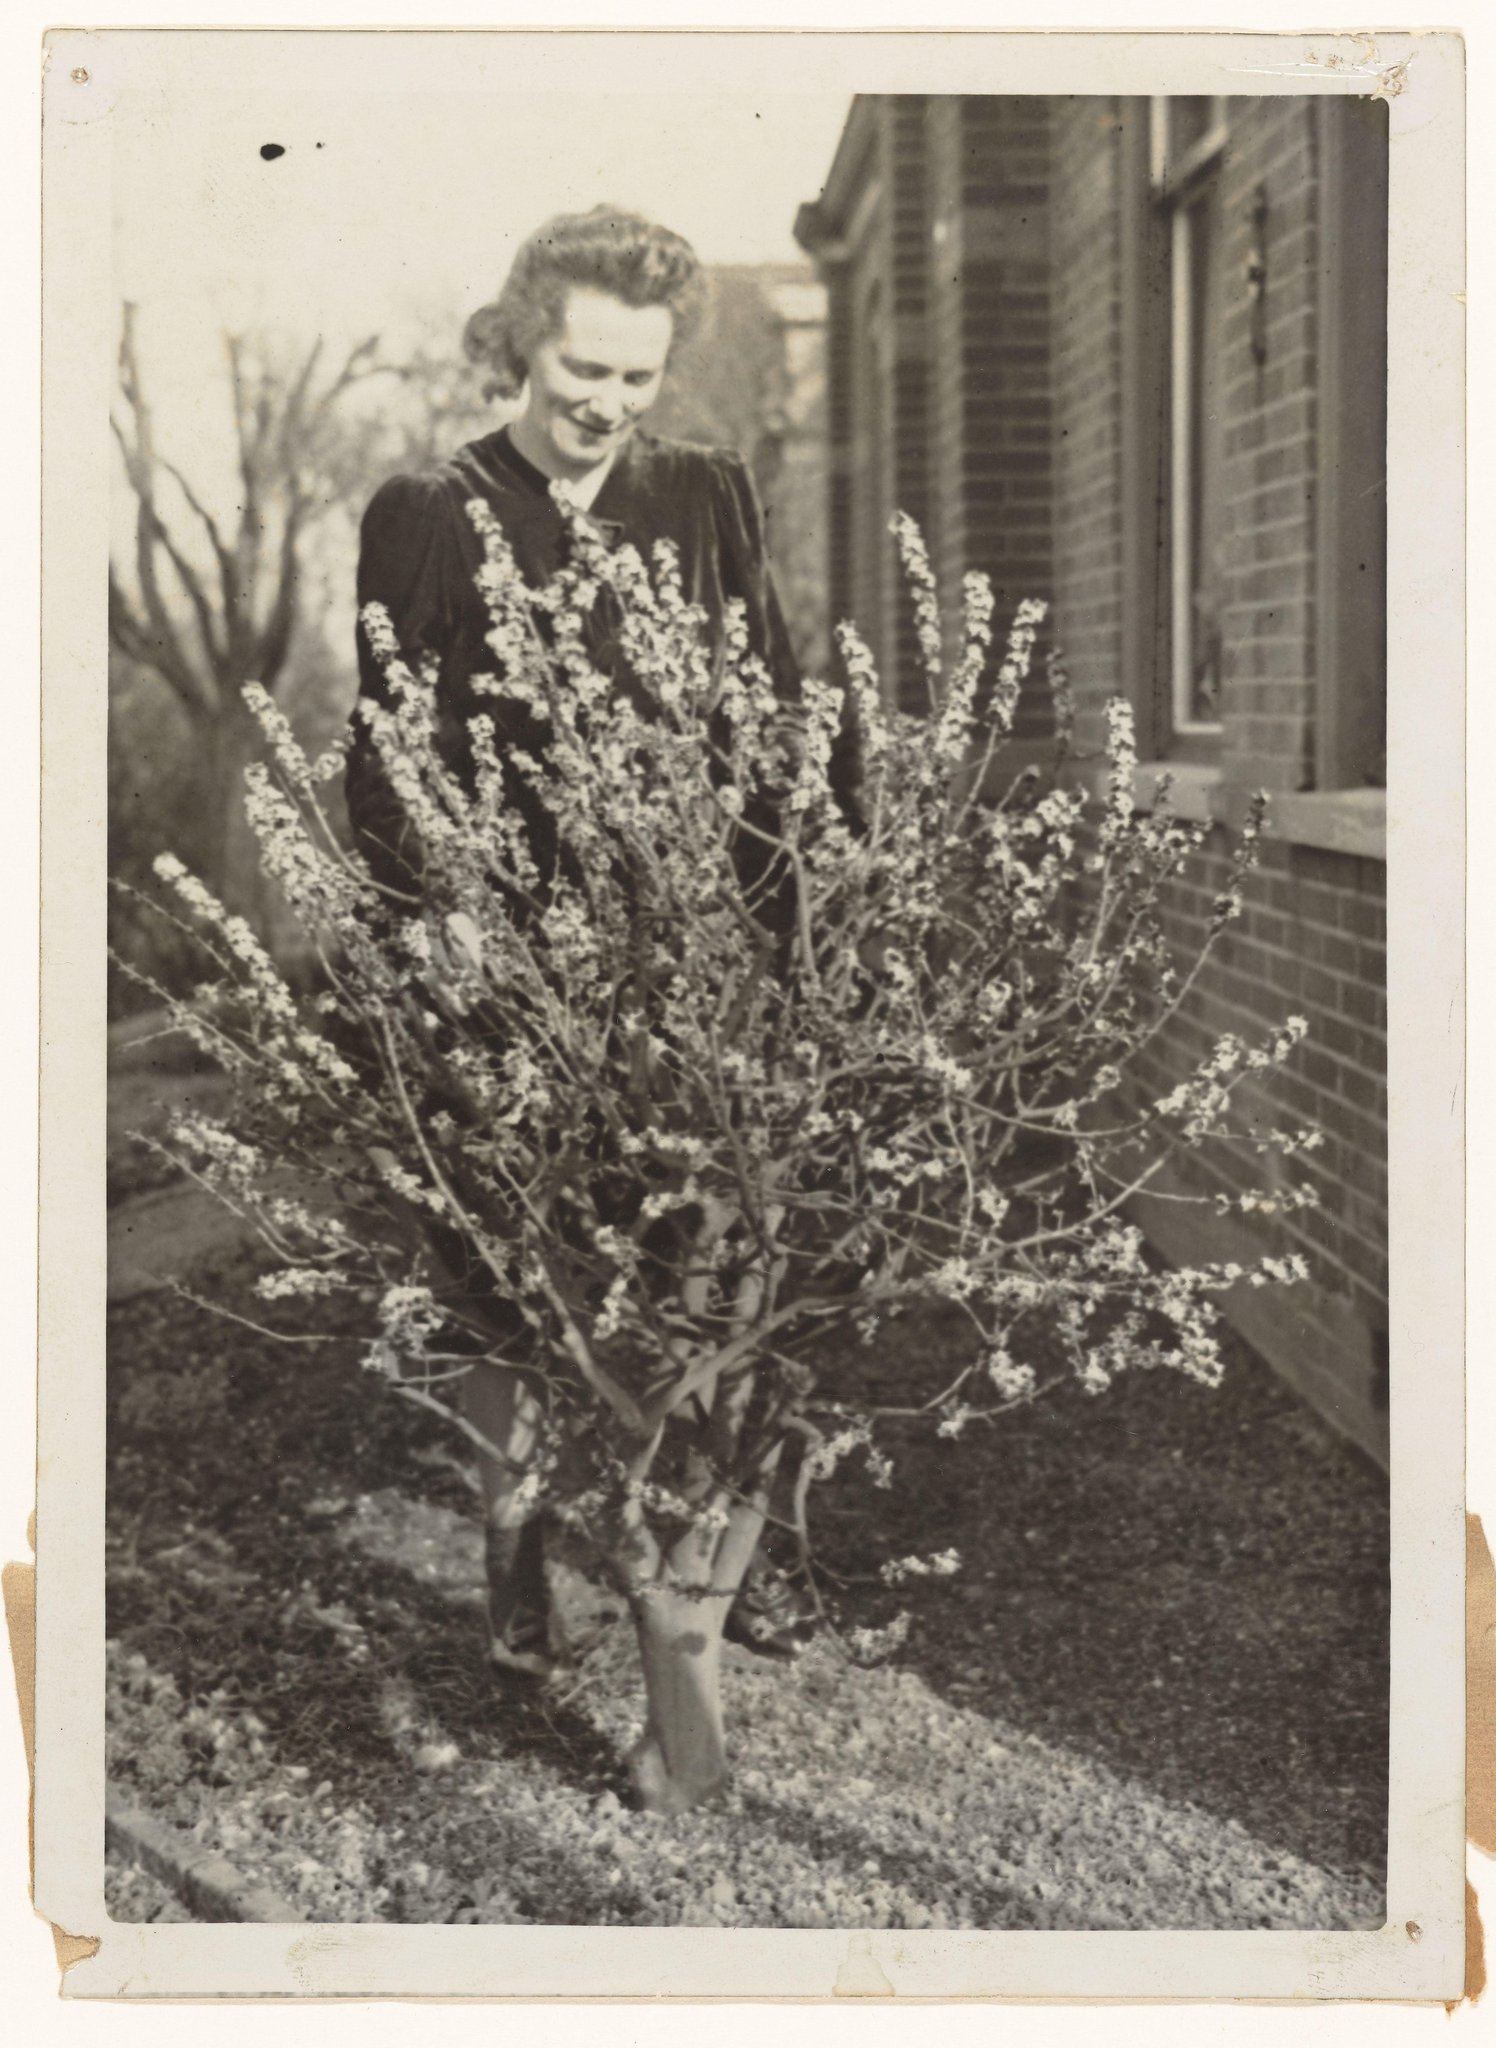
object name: photograph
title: Lente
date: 1943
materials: photographic support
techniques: gelatin silver print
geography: north holland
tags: trees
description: In Zwaag staat een peperboompje in bloei, maart 1943.